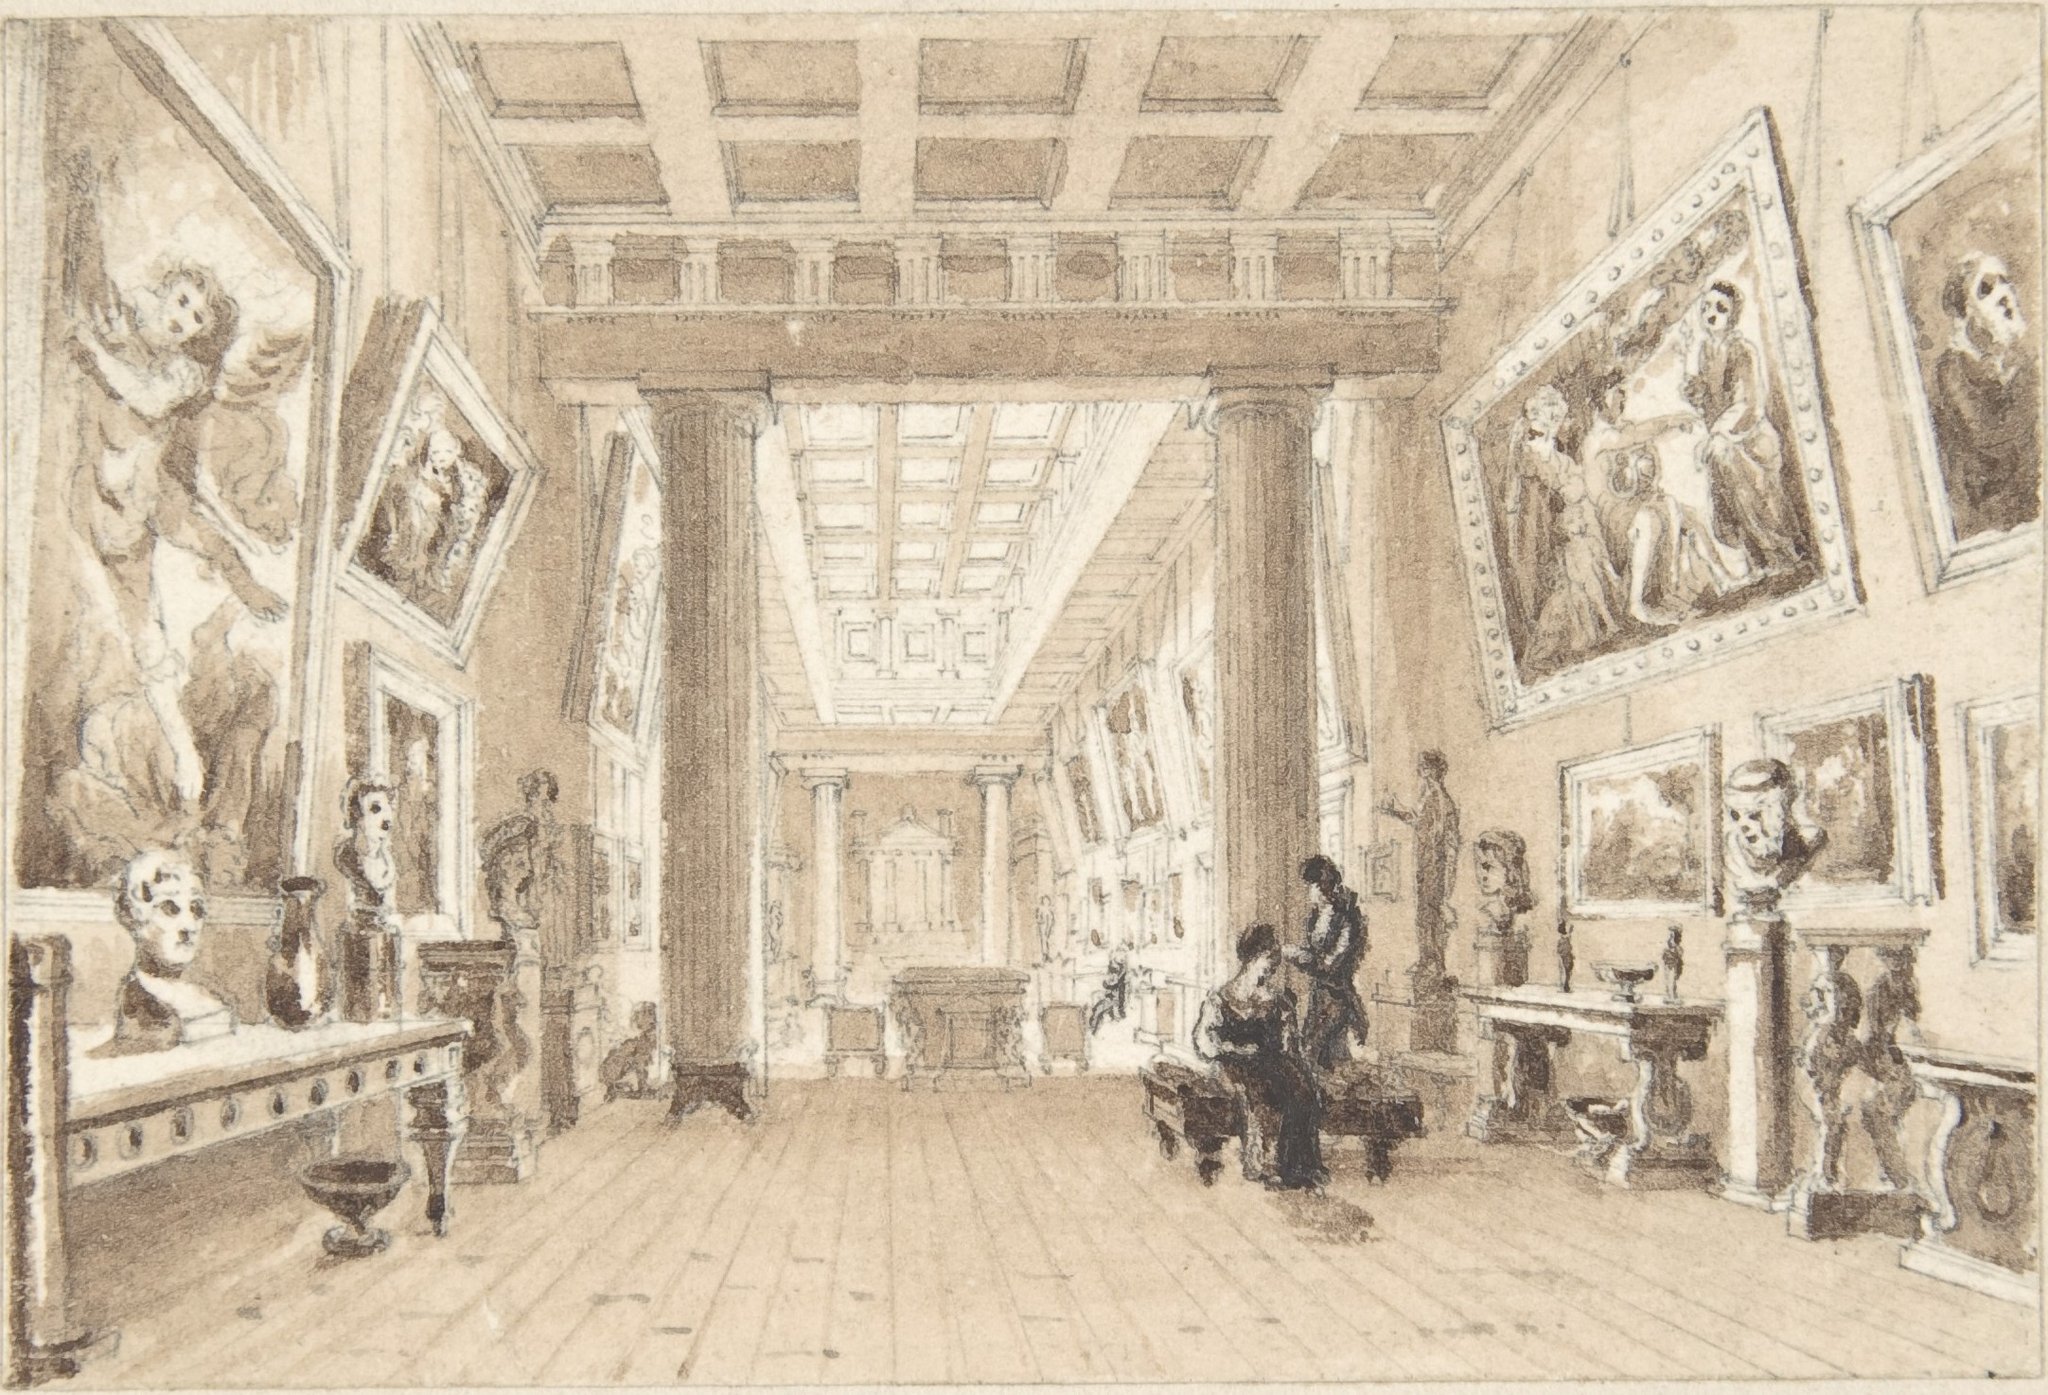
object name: drawing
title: Interior of Thomas Hope's Picture Gallery, Duchess Street, London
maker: william henry bartlett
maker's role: artist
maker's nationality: british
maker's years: 1809-1854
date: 1825-1854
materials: graphite, ink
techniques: brush, pen, wash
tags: sculpture,interiors,women